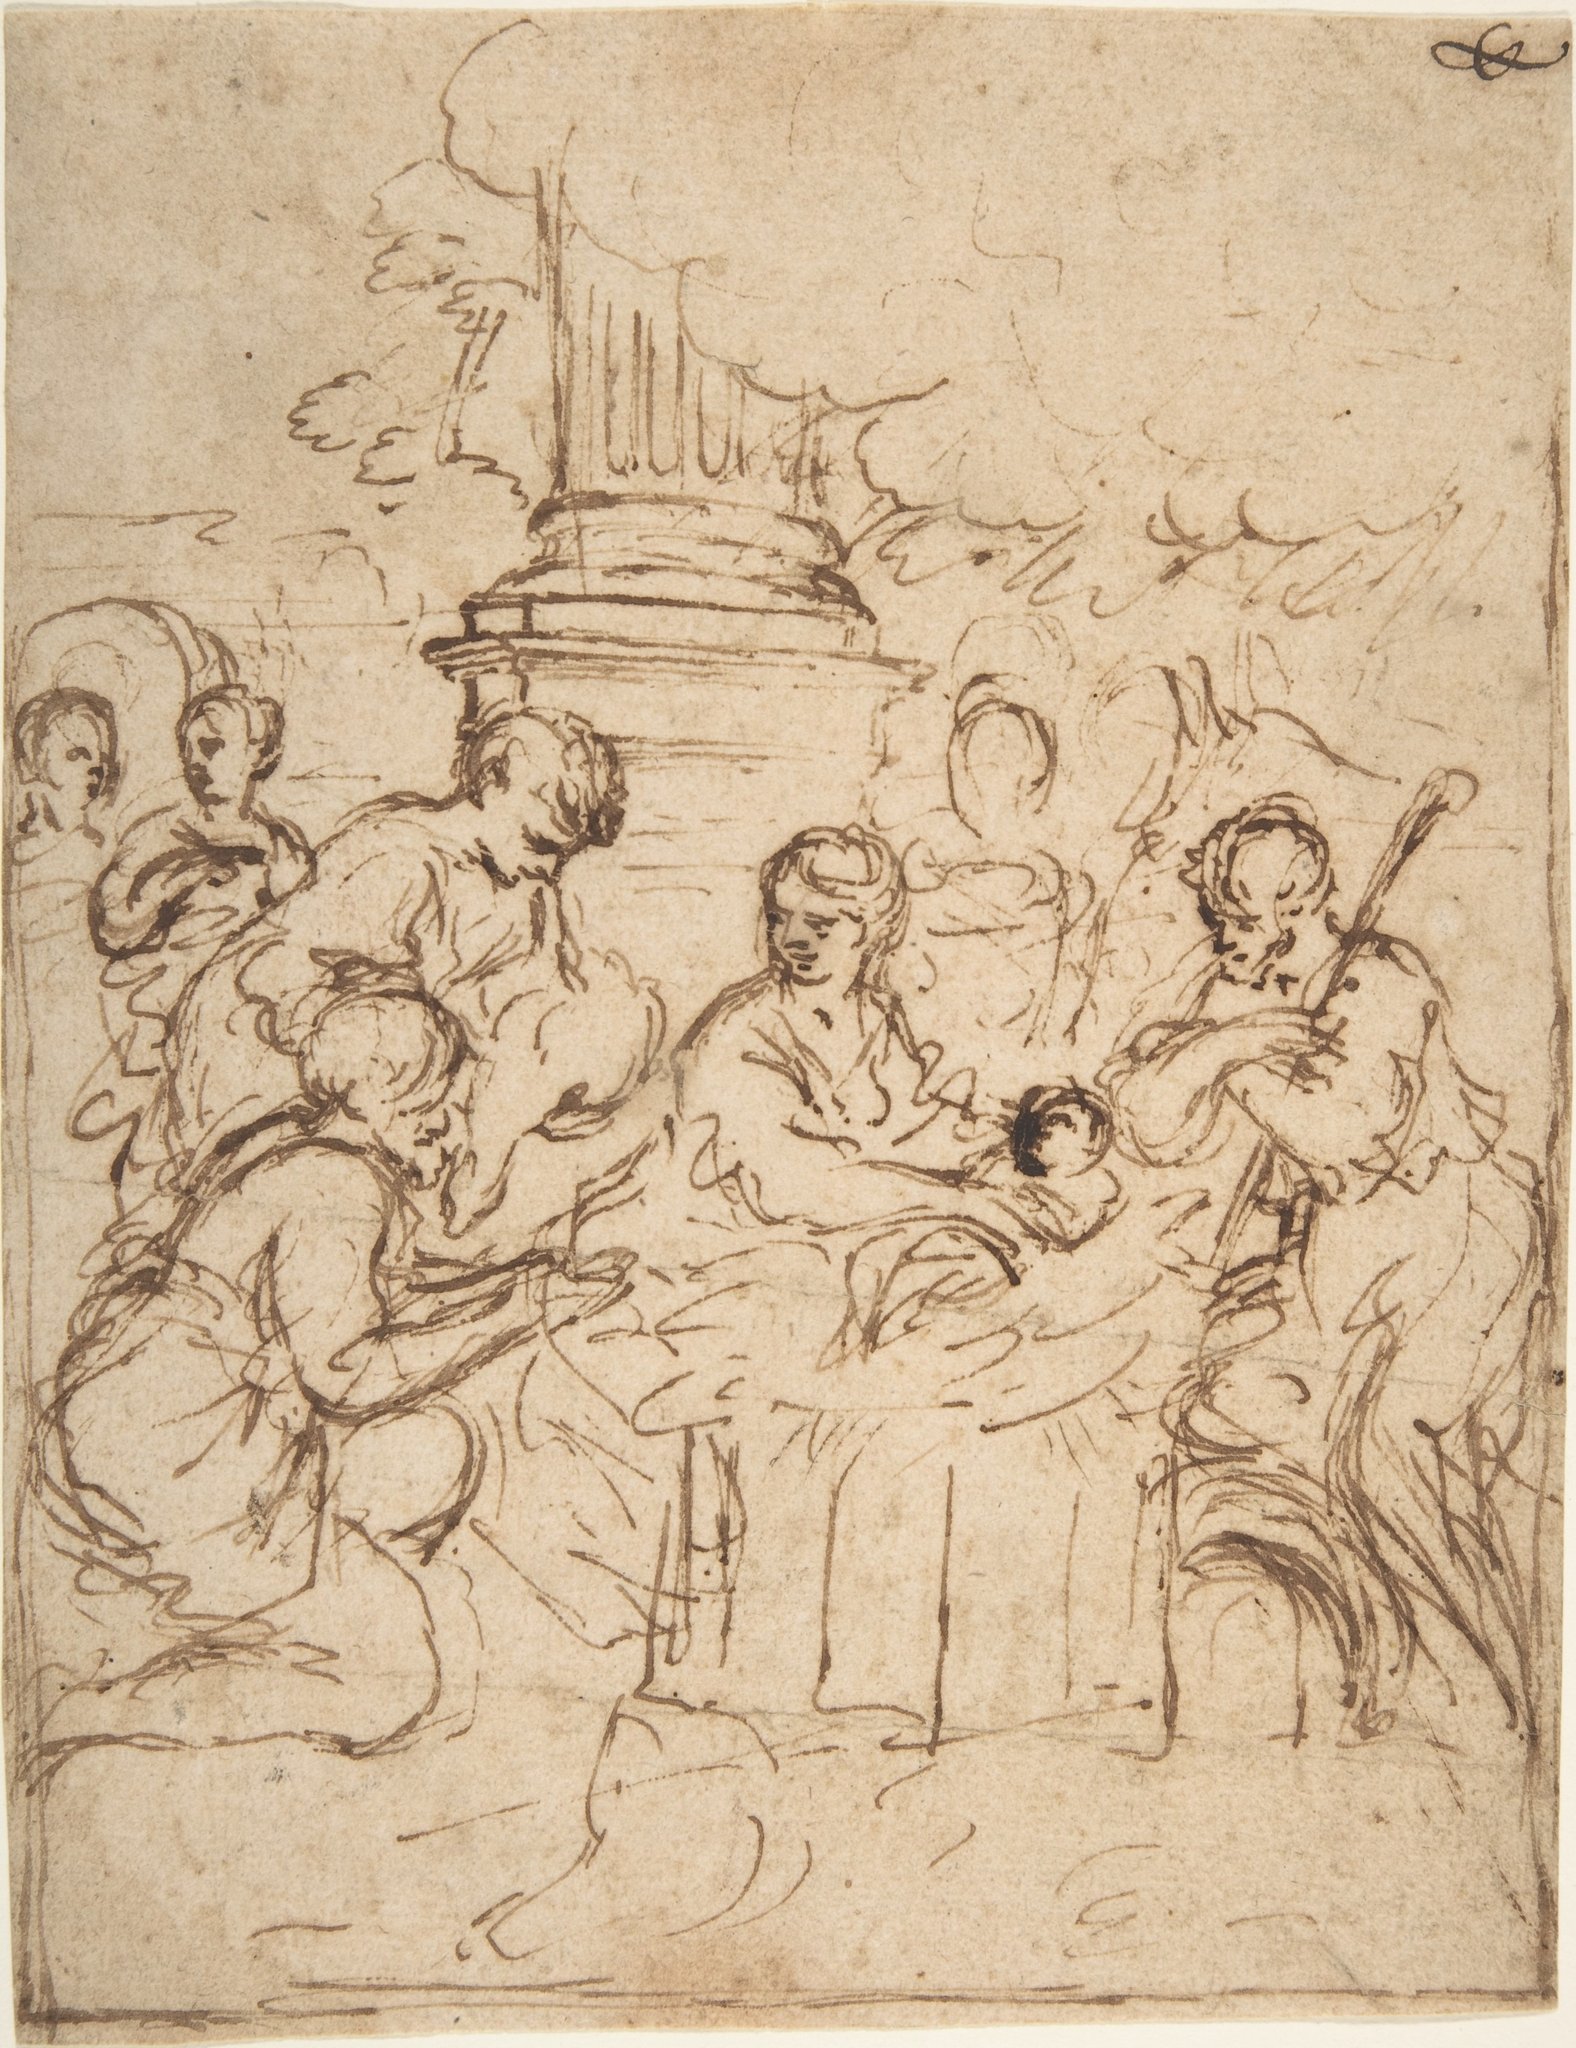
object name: drawing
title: The Adoration of the Shepherds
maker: pietro da cortona (pietro berrettini)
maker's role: artist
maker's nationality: italian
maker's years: 1596-1669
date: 1601-1700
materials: ink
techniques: pen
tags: adoration of the shepherds